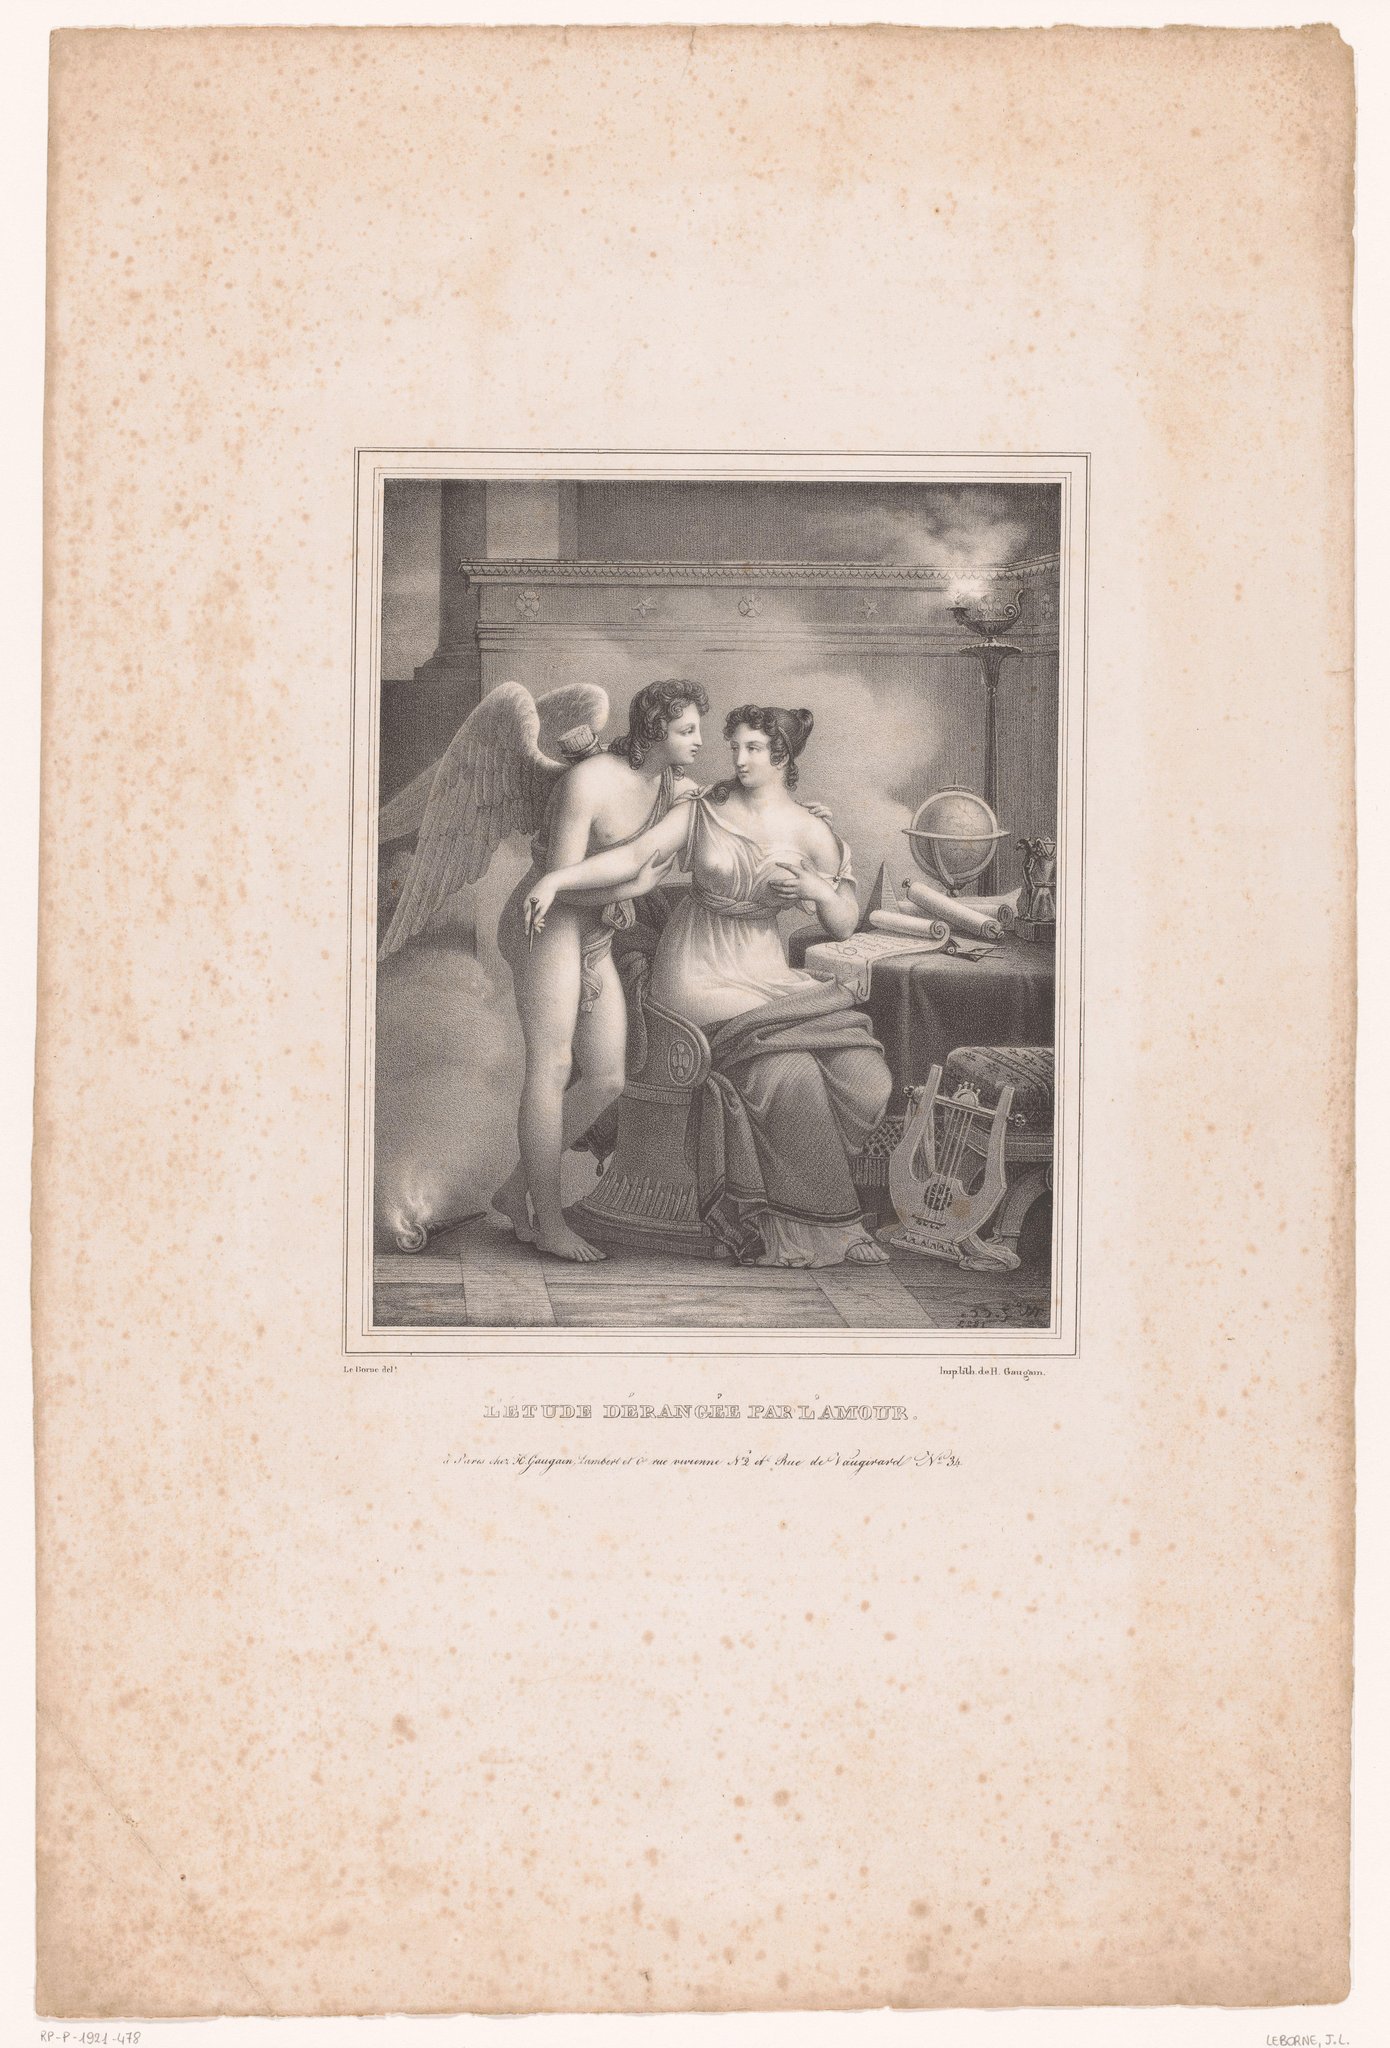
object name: print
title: L'étude dérangée par l'amour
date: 1823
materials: paper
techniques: lithograph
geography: paris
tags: gripping someone by the arm, studying ~ university - bb - female student, other non-aggressive activities of cupid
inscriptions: collector's mark: Lugt 2233